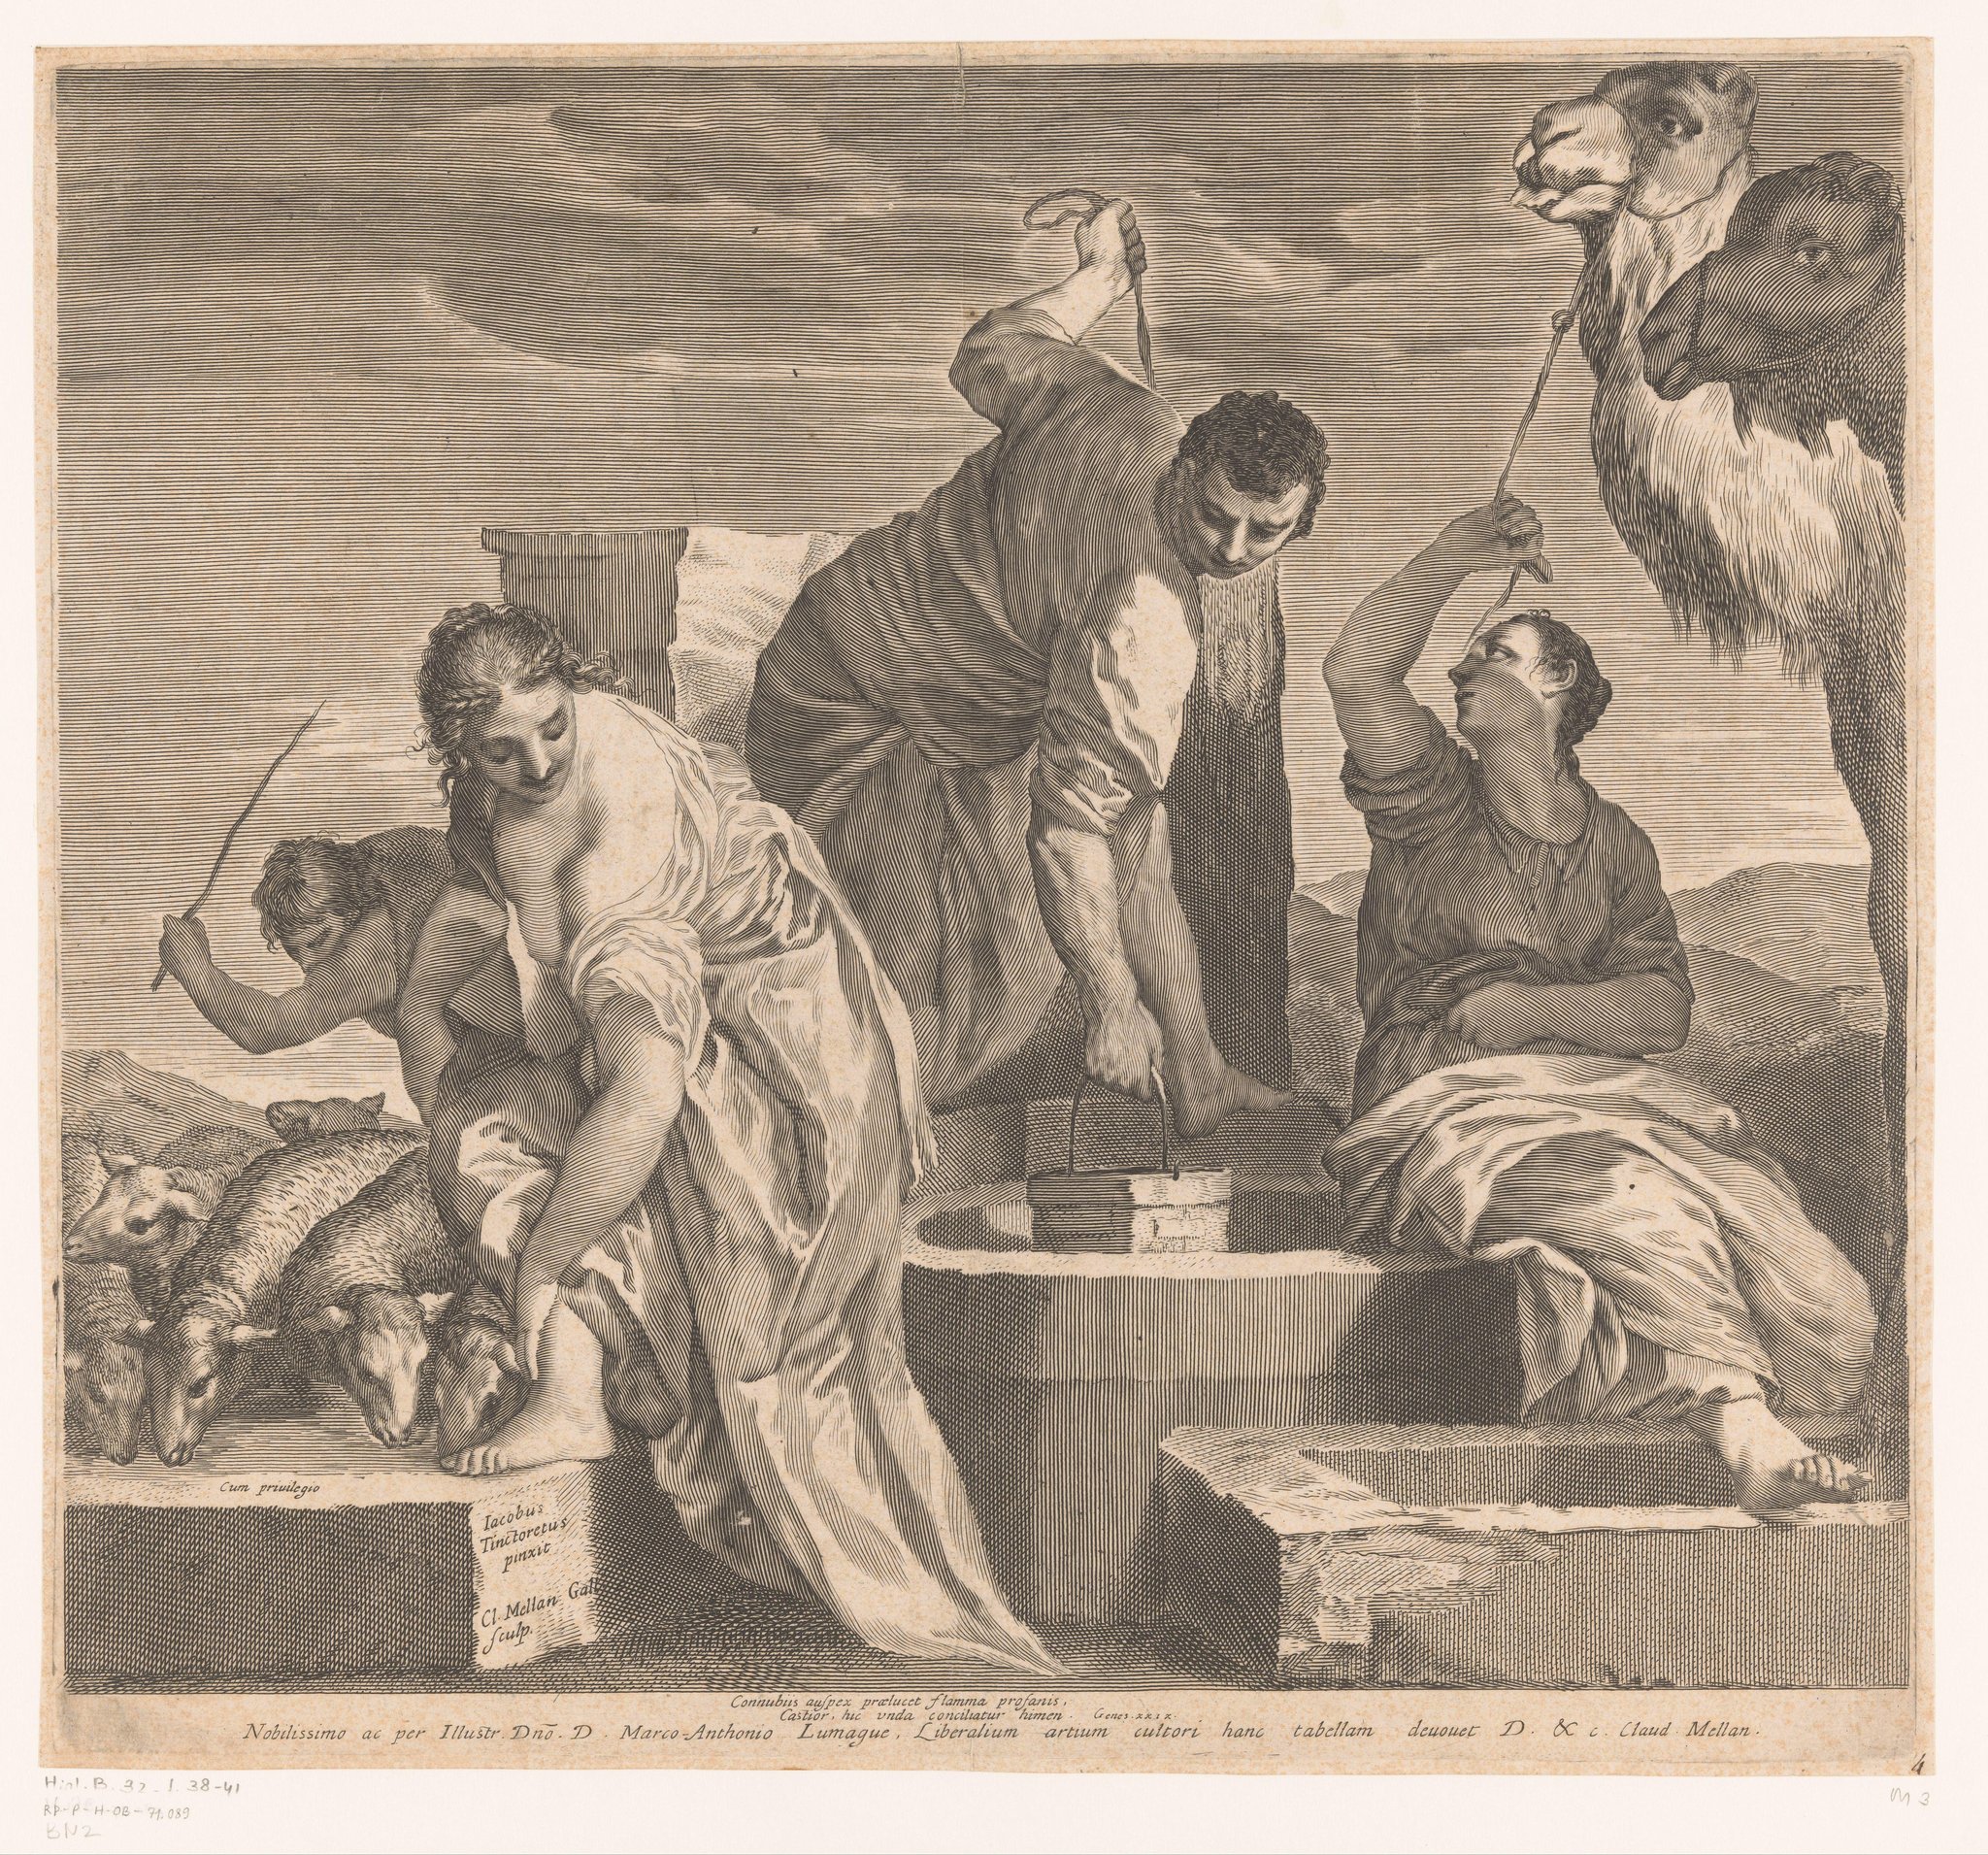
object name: print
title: Jaokob geeft de kudde van Rachel te drinken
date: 1608-1688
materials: paper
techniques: engraving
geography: france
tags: jacob moves the stone which covers the opening of the well and waters rachel's sheep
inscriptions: collector's mark: Lugt 10, collector's mark: Lugt 11, collector's mark: ‘Hinloopen’, number: ‘4’